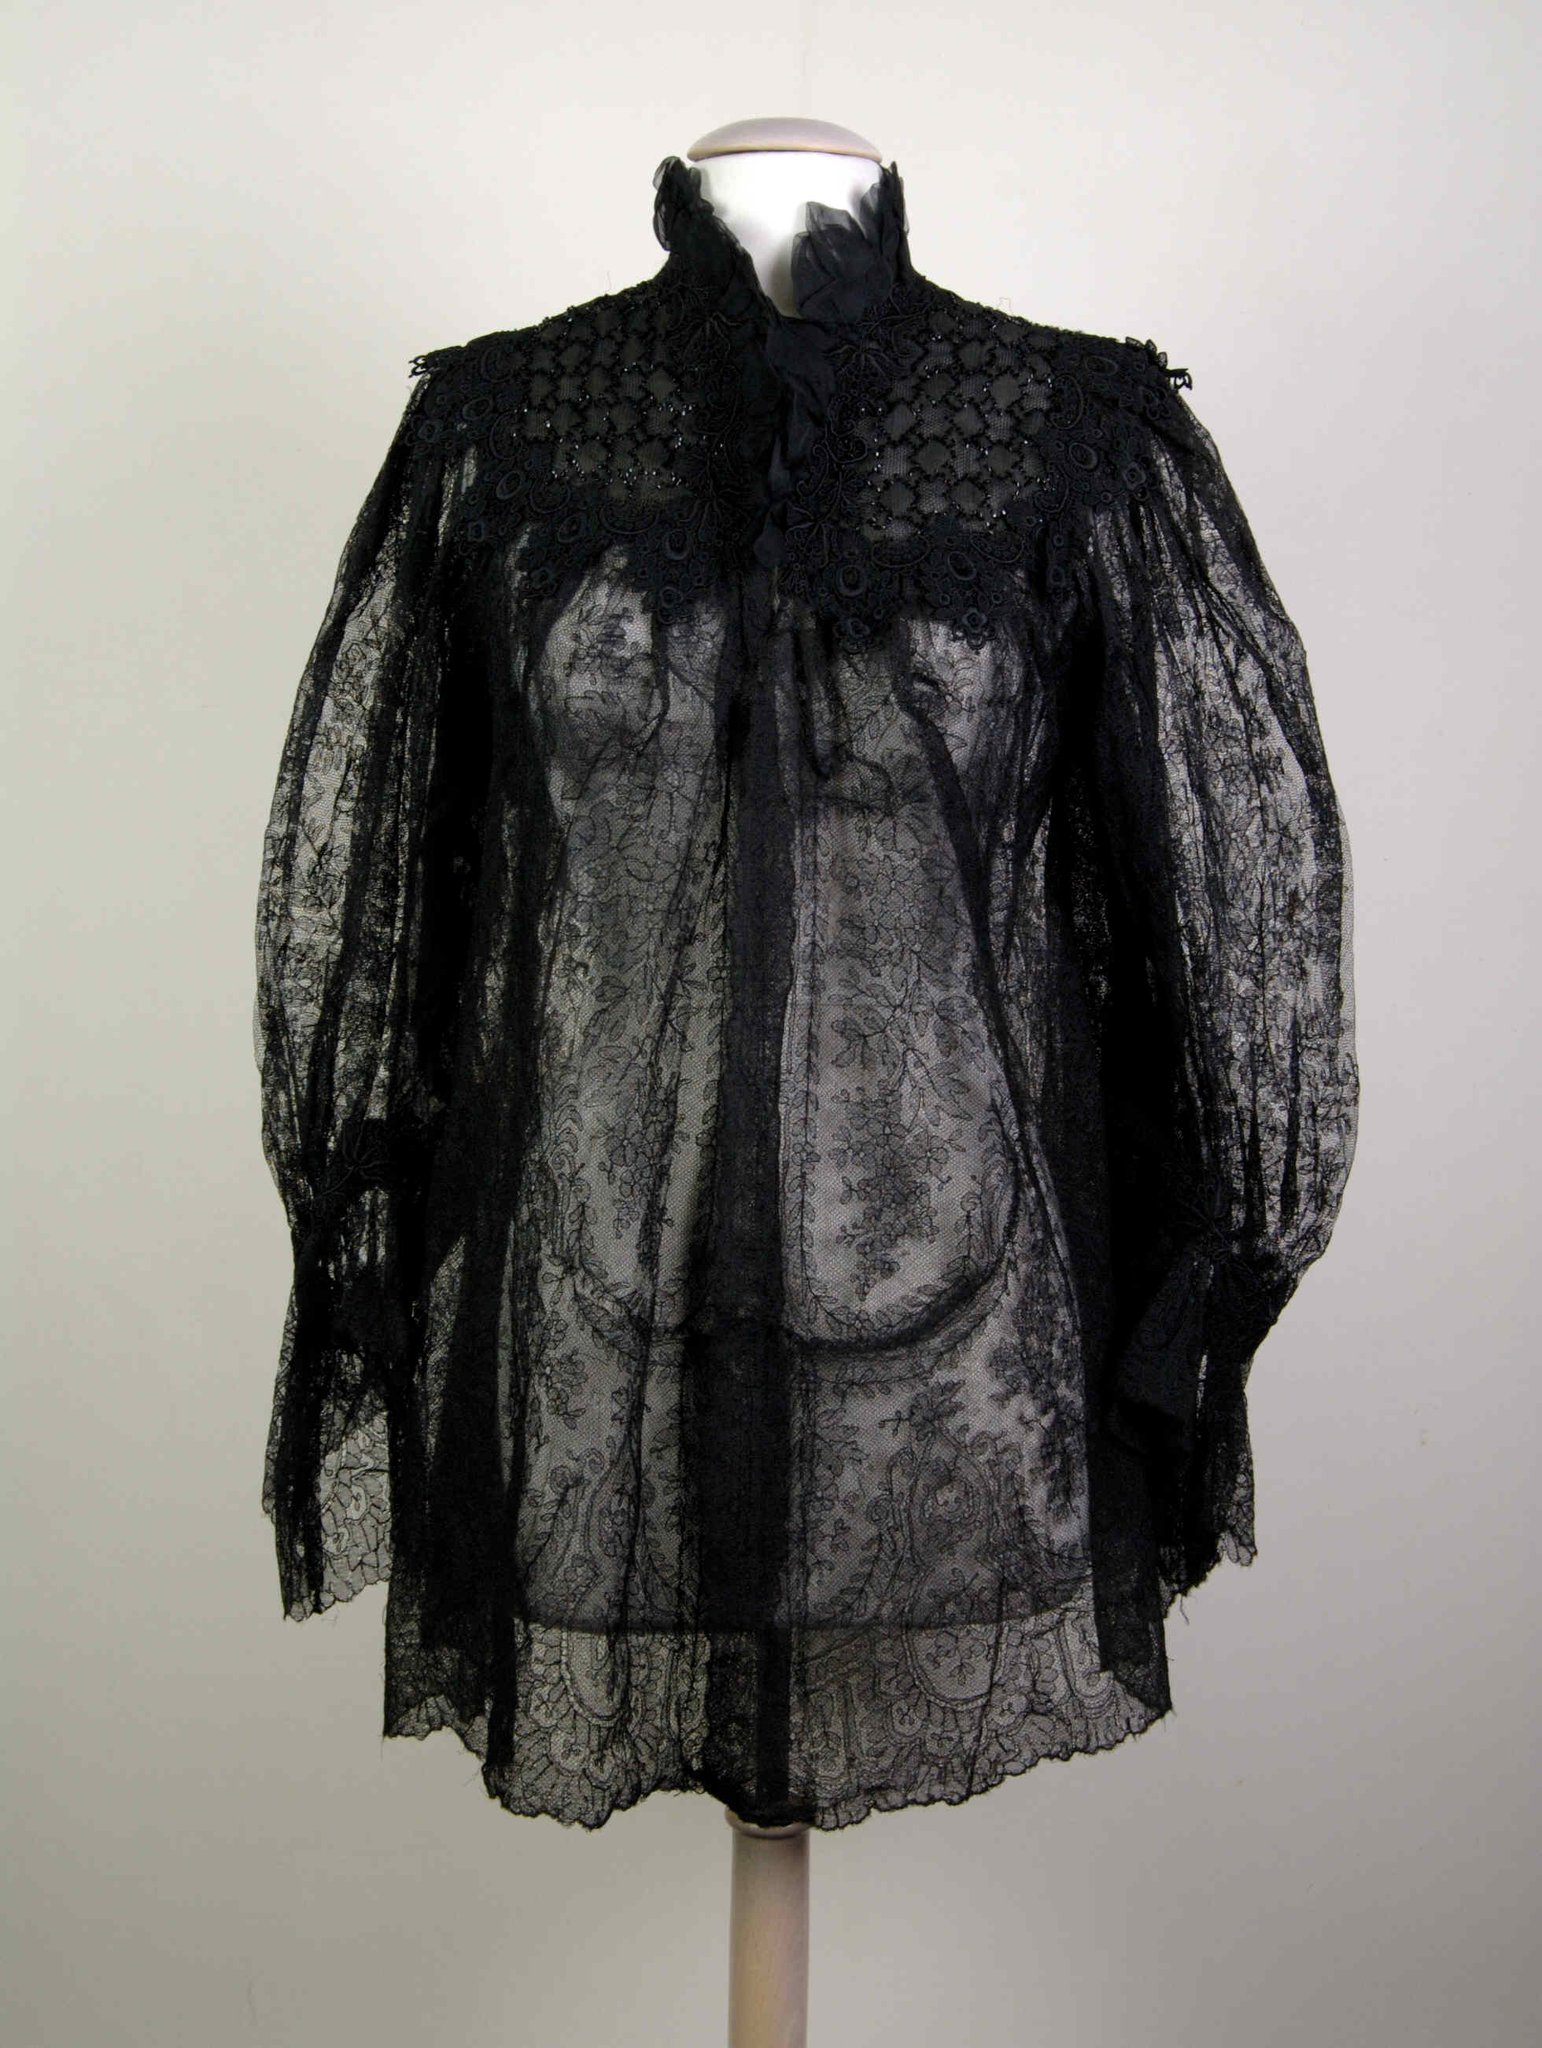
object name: jacket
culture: american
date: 1870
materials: silk